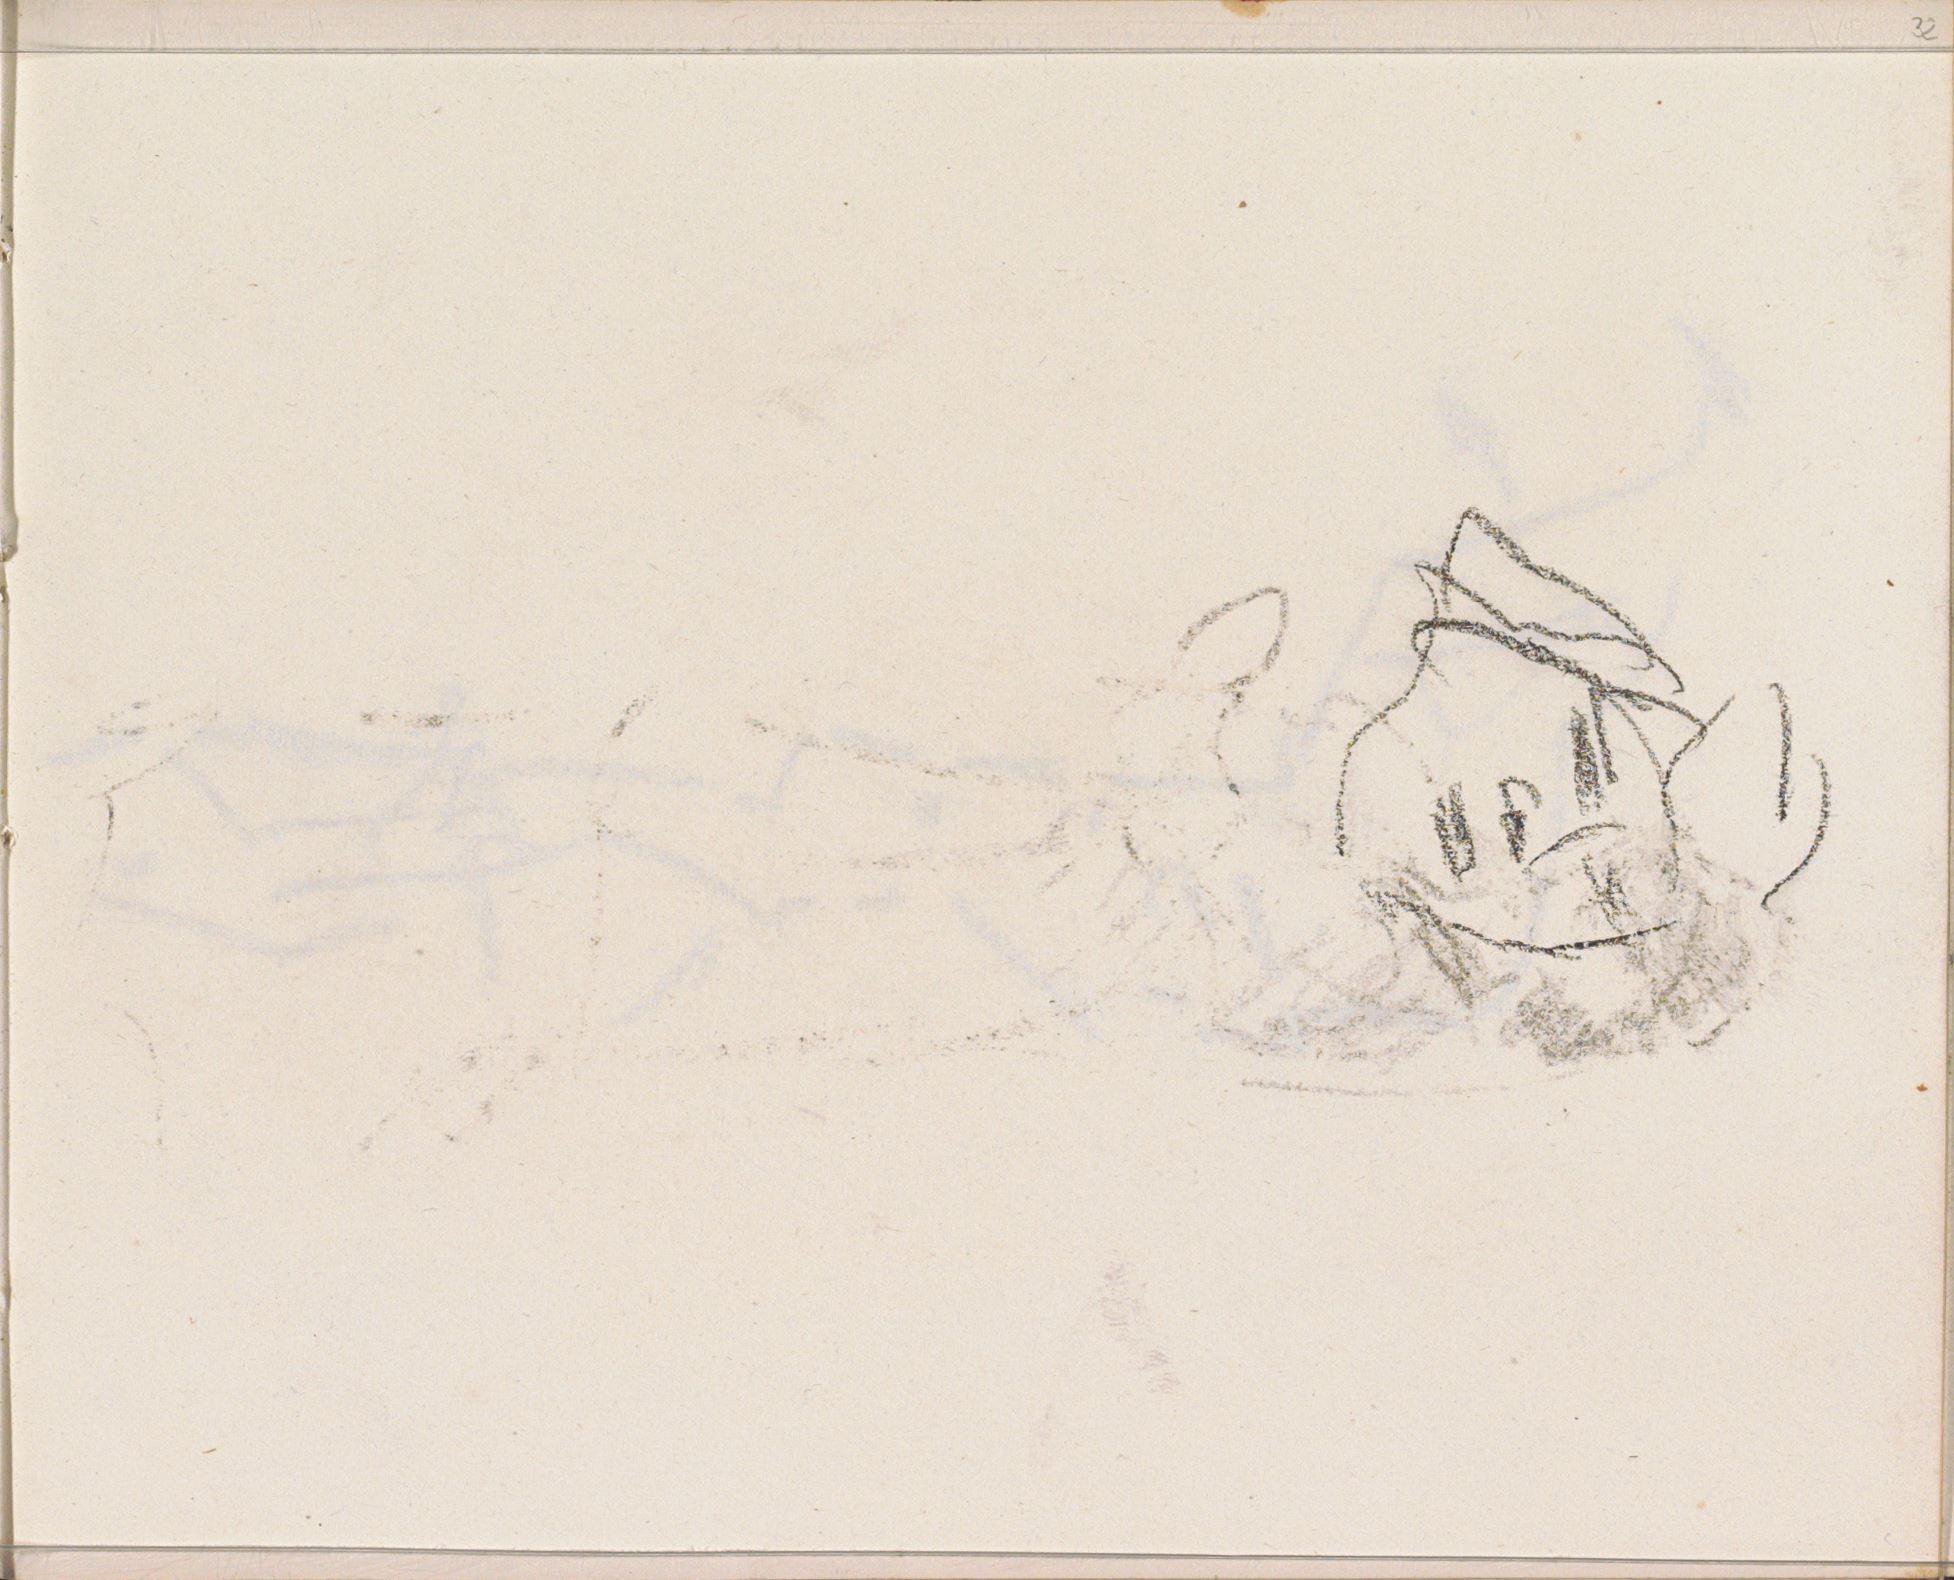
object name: sketchbook leaf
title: Vrouwenhoofd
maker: isaac israels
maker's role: draughtsman, painter, print maker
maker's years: 1865-1934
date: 1875-1934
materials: chalk, paper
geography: the hague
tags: head (human) - aa - female human figure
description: Pagina 32 uit schetsboek XLIII met 61 pagina's.